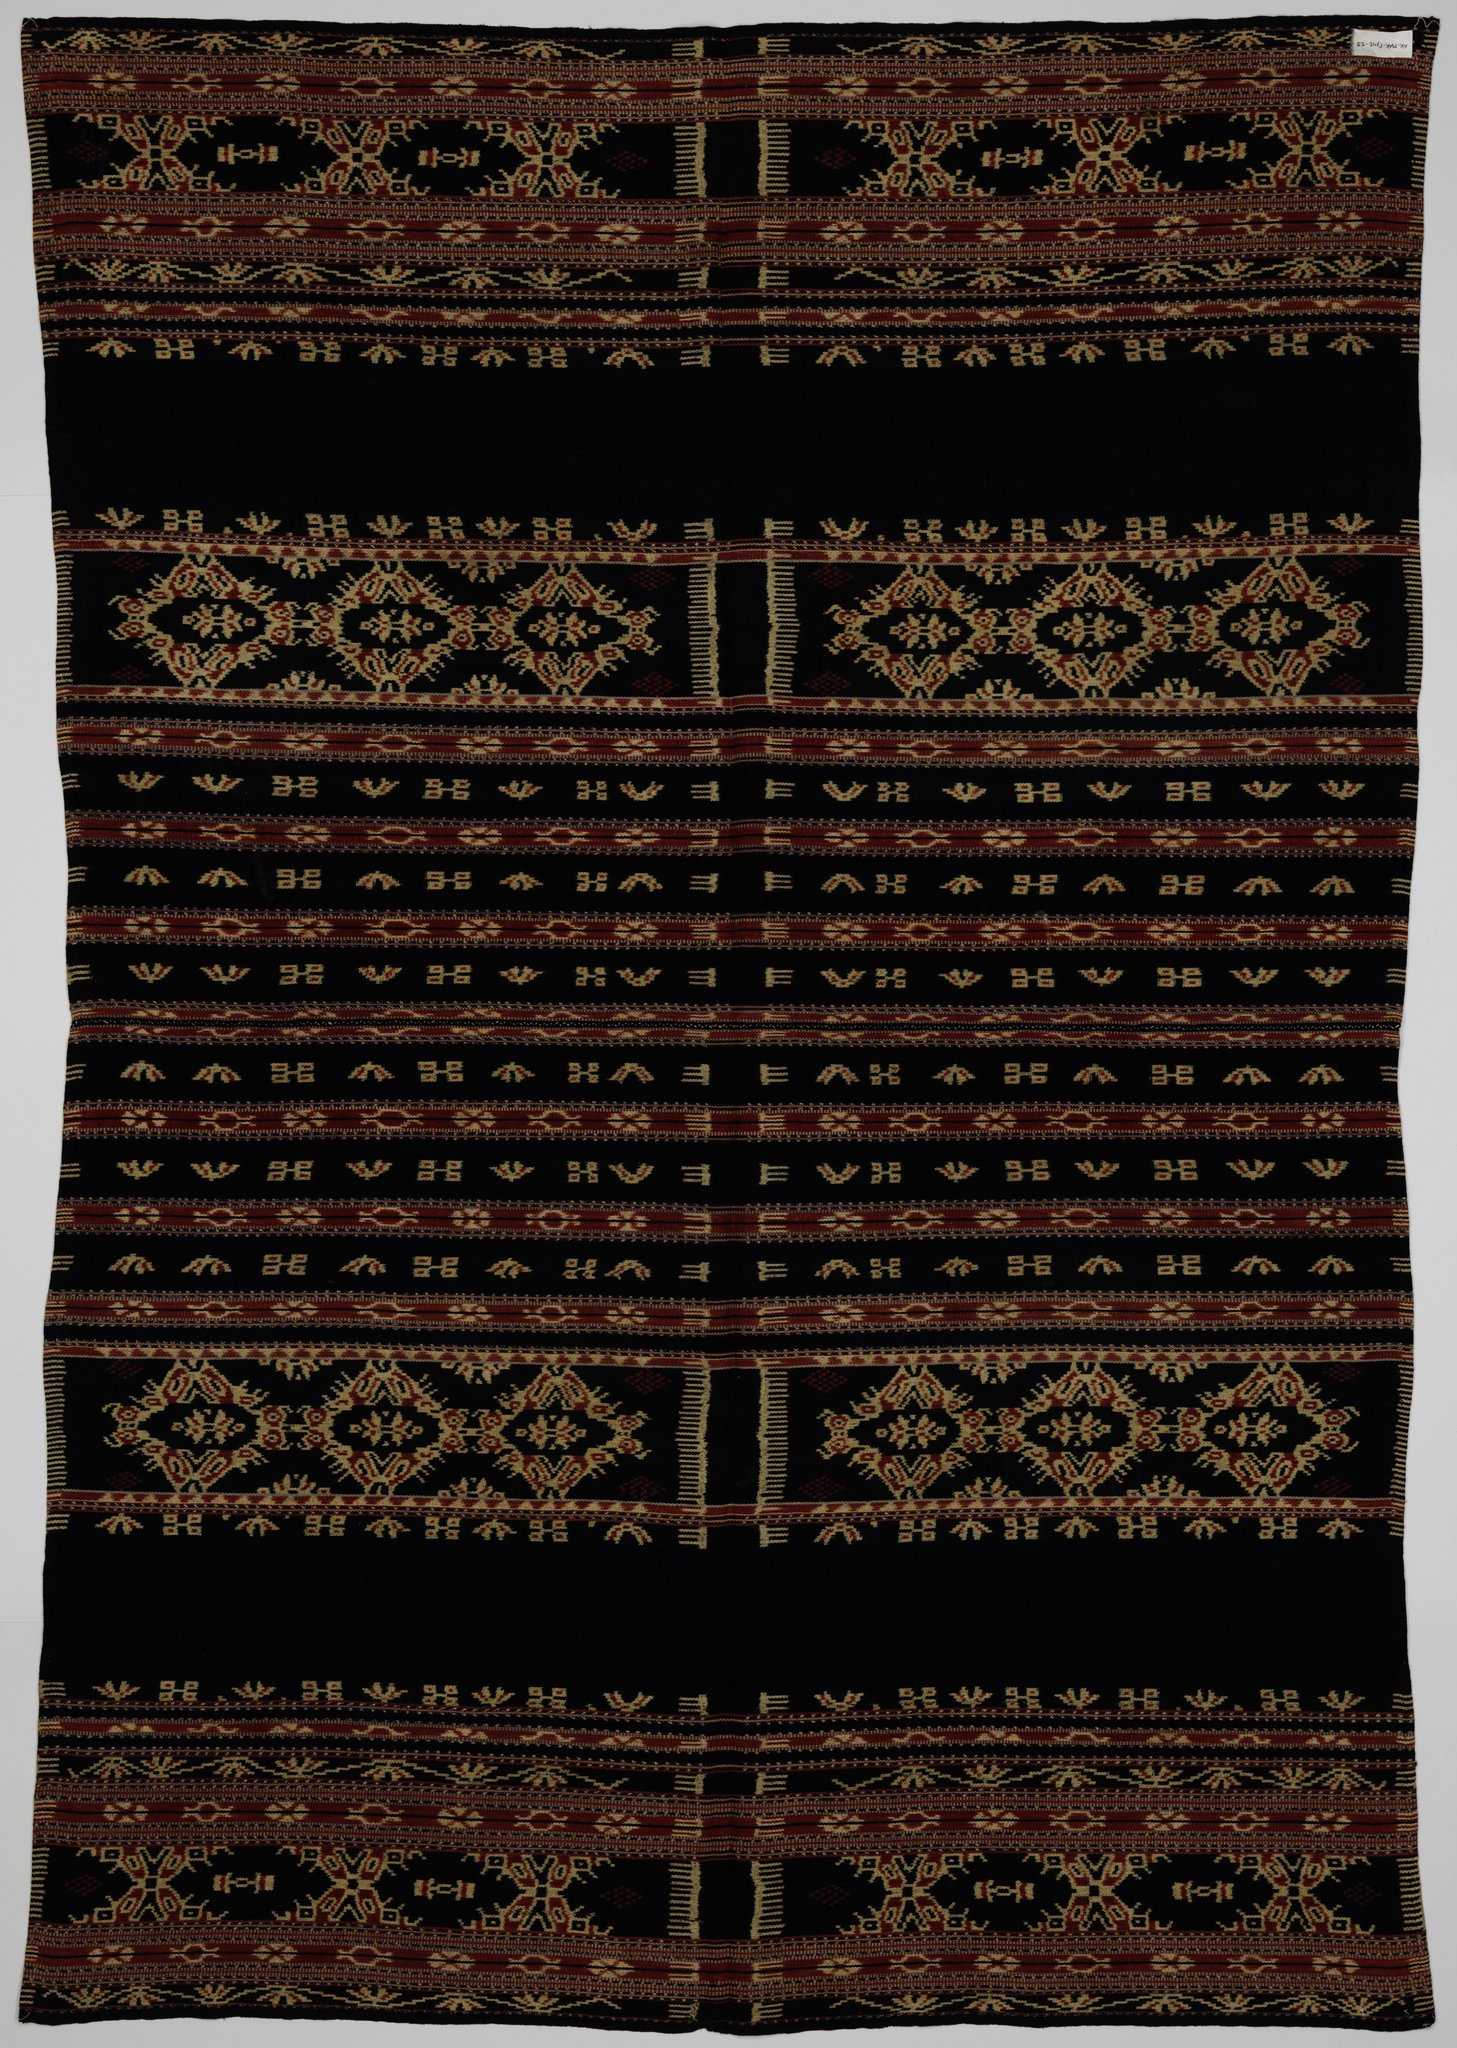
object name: cloth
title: Sarung worapi; sarung ei raja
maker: Anonymous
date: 1900-1949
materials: cotton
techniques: weave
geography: savoe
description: De doeken van Sawu zijn zwart, donkerblauw en roest rood gekleurd. De motieven van de doeken geven de afstamming van de gebruiker aan: van de Hubi Ae, de grote clan of van de Hubi Iki, de kleine clan. Sawu is tevens bekend om de doeken met rozen, bloementakken, vogels en vazen. Deze motieven zijn overgenomen van Nederlandse haakwerk patronen en worden niet gecombineerd met traditionele motieven. Bestemd voor vrouwen uit de Hubi Ae (de grotere bloemen) groep; dat is de hogere adel.